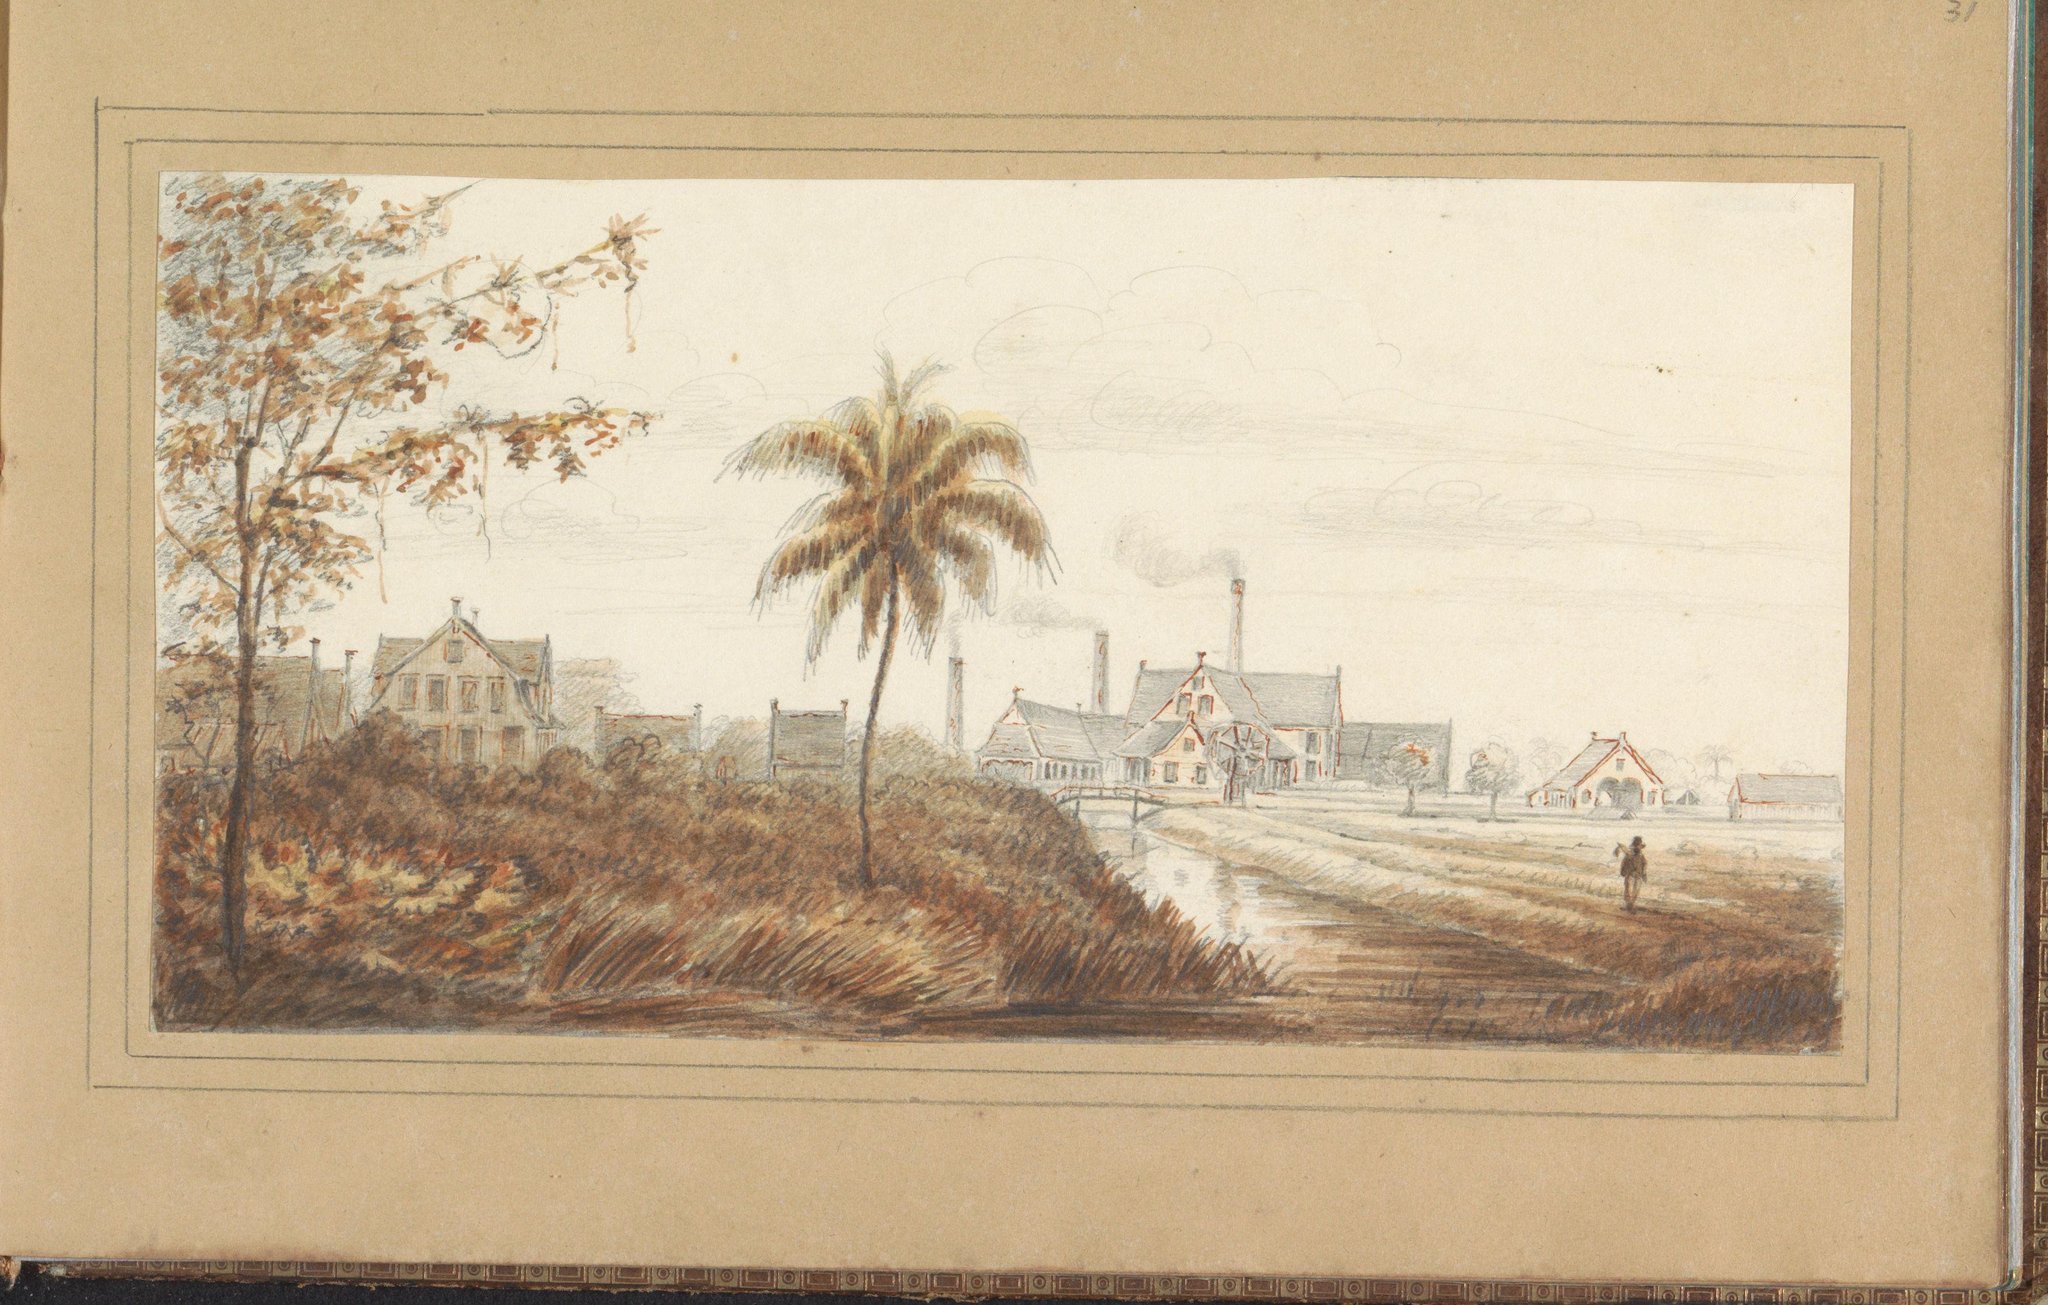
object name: album leaf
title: Gezicht op plantage Visserszorg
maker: jacob marius adriaan martini van geffen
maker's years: 1821-1866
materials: ink, paper, pencil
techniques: brush, pen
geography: suriname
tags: suriname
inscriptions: inscription: ‘.’